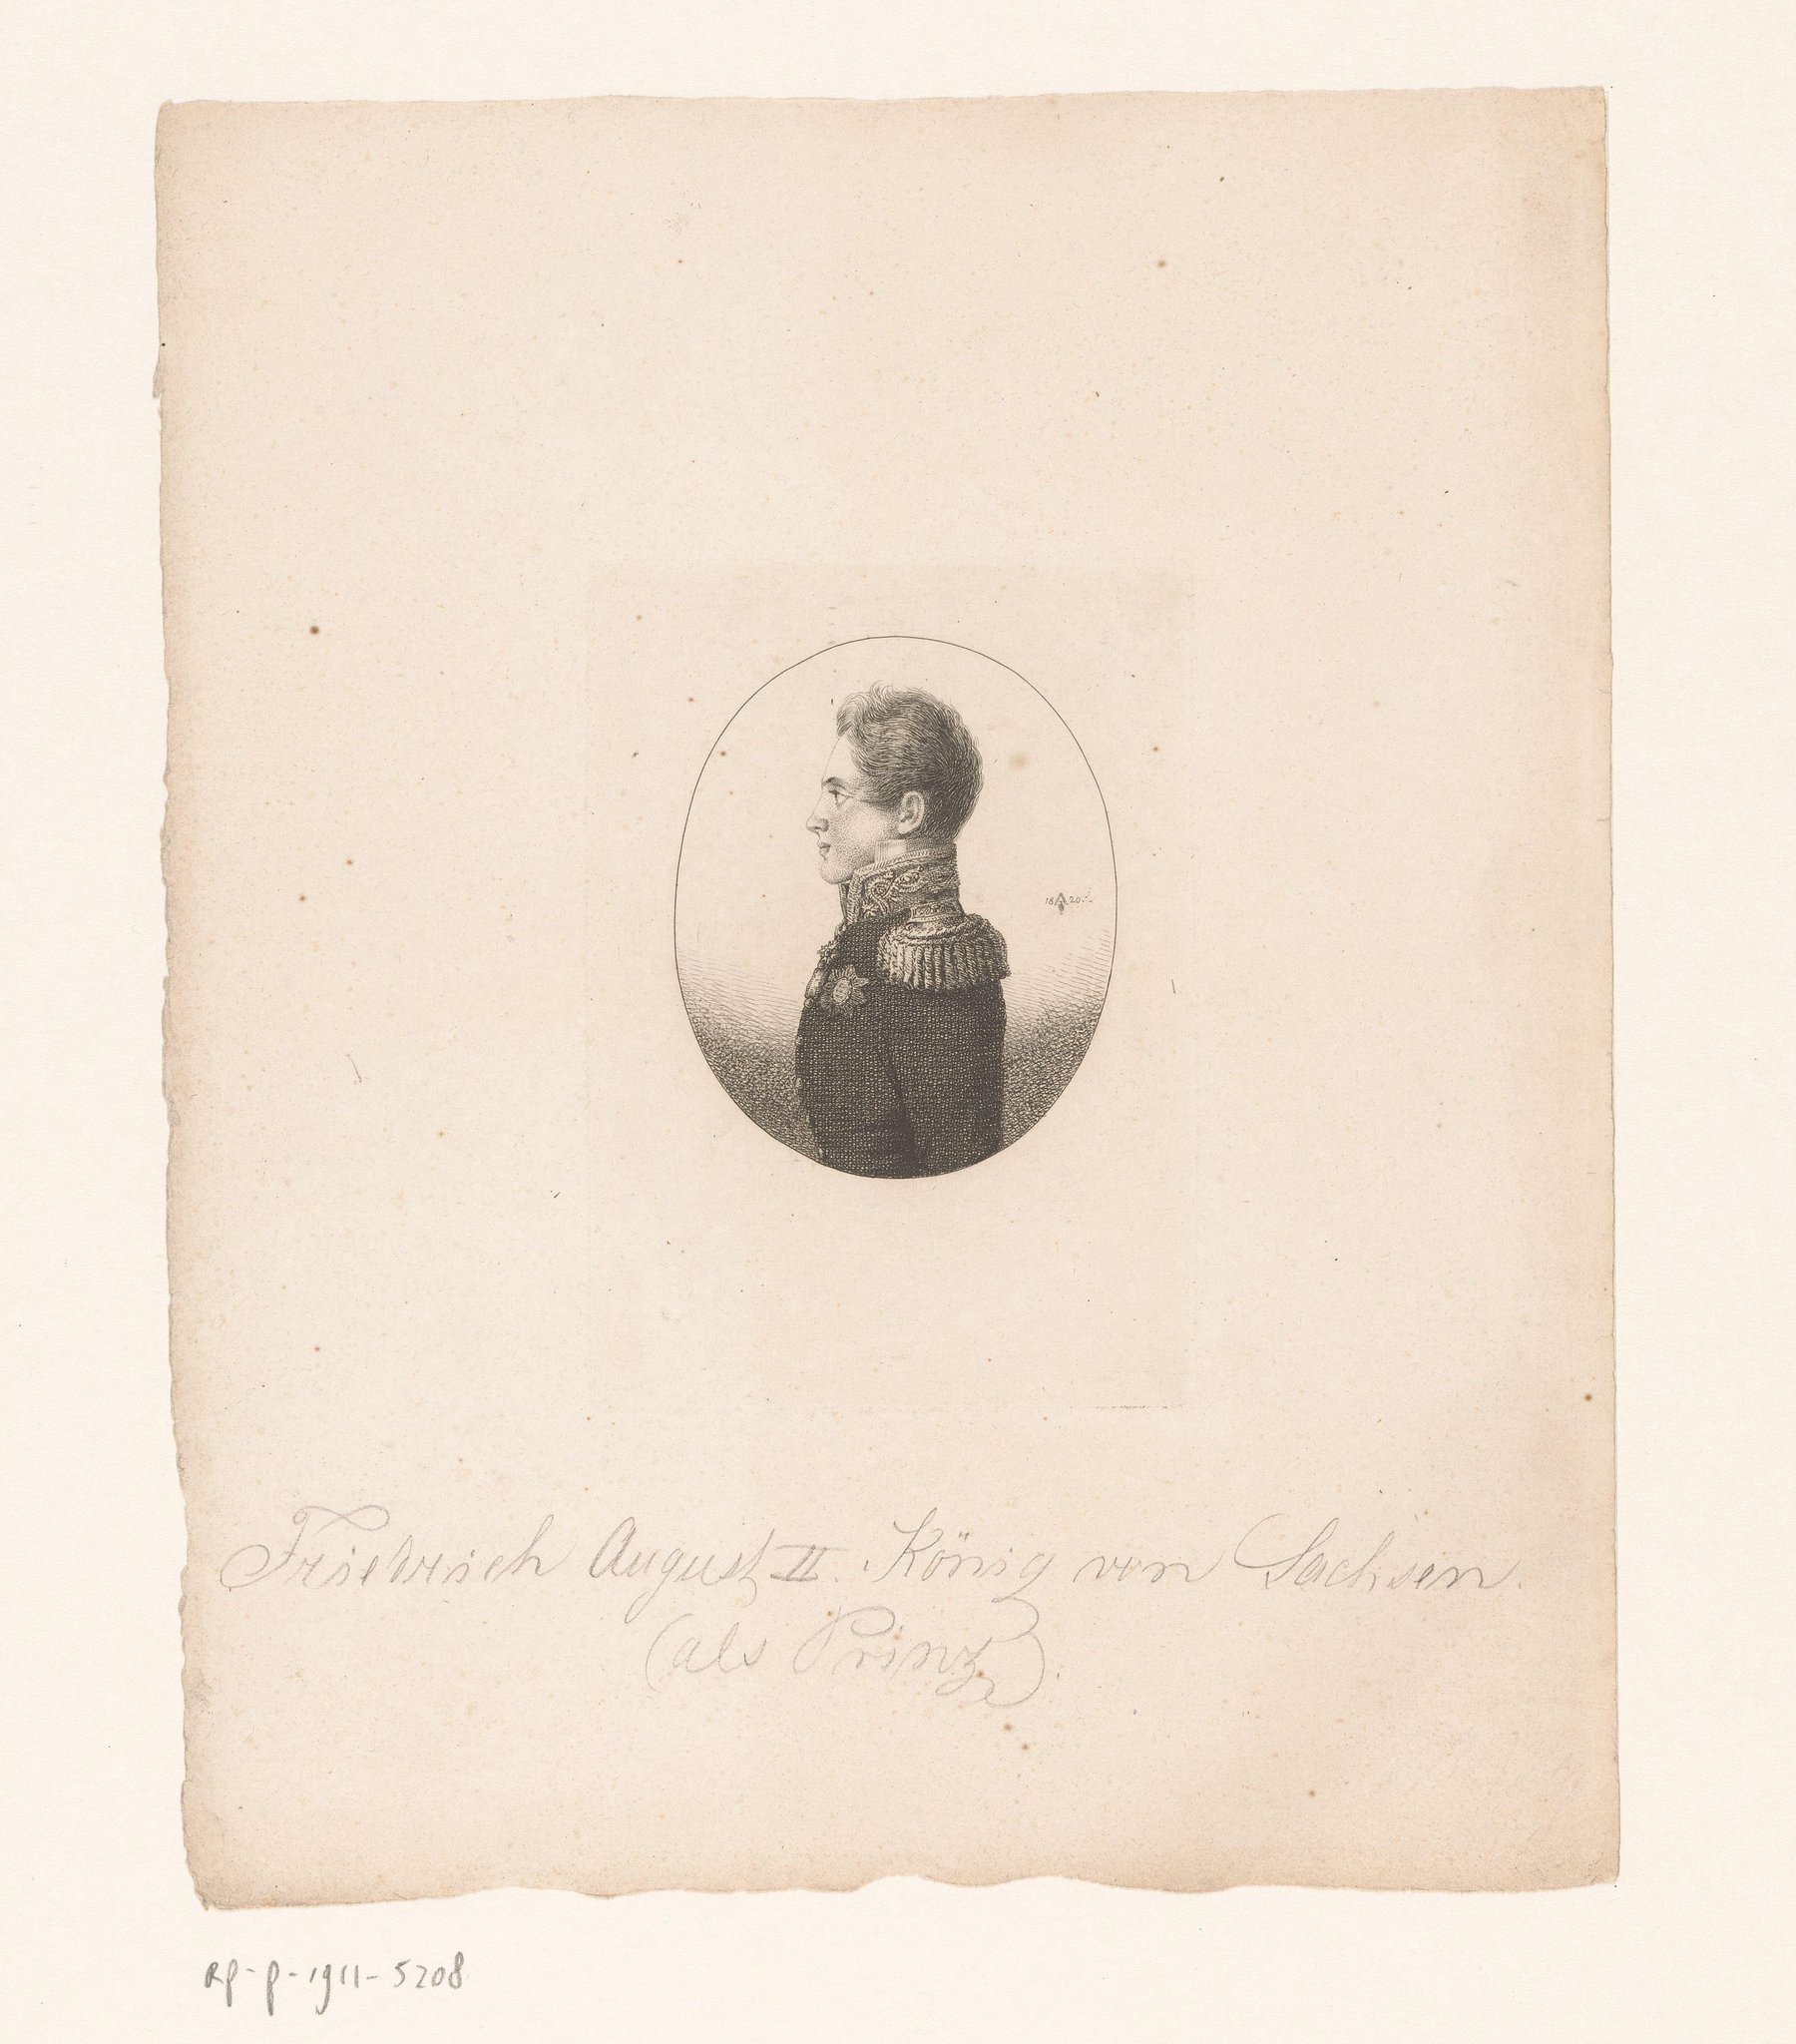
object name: print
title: Portret van Frederik August II van Saksen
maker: ferdinand karl theodor christoph peter freiherr von lütgendorff-leinburg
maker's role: print maker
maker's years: 1785-1858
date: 1820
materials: paper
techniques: etching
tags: historical persons, medals and other marks of military honour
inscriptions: collector's mark: Lugt 2228